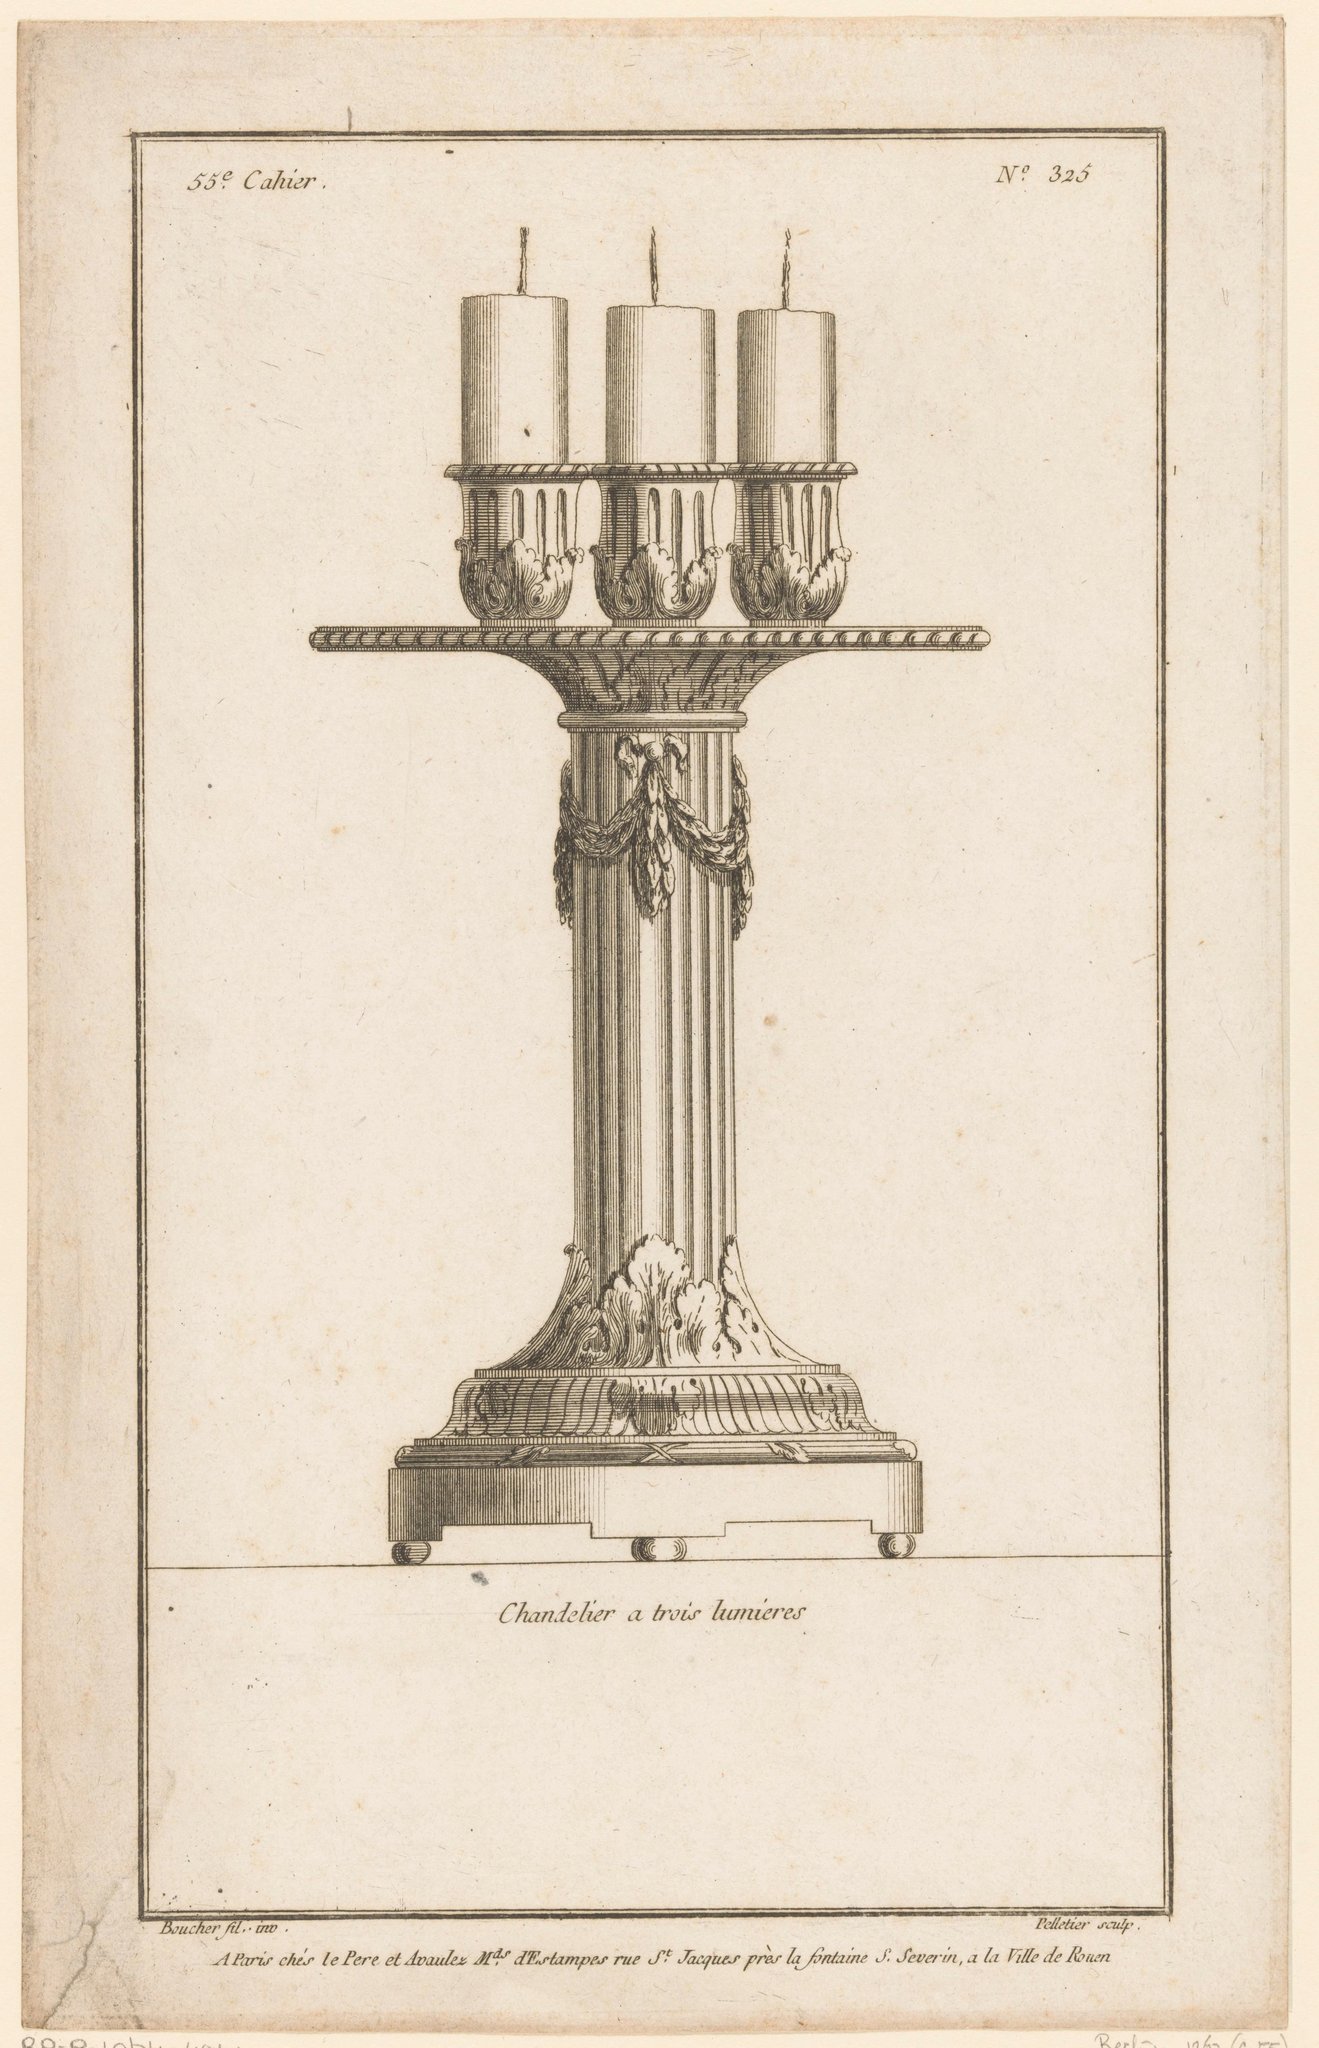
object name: ornament print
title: Chandelier a trois lumieres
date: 1772-1779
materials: paper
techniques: engraving, etching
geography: paris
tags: chandelier, candelabrum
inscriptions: collector's mark: Lugt 2228, collector's mark: Lugt 2760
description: Een geornamenteerde kandelaar met drie kaarsen. Prentnummer 325.